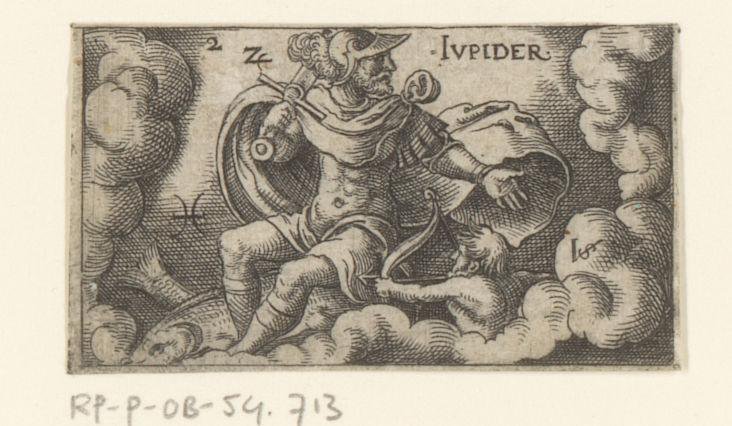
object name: print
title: Personificaties van zeven planeten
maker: virgilius solis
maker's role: draughtsman, print maker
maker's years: 1514-1562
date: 1524-1562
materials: paper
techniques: engraving, etching, intaglio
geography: nuremberg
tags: clouds, (story of) jupiter (zeus), jupiter (planet)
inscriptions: number: ‘54’, collector's mark: Lugt 2228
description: Maakt deel uit van een serie die bestaat uit vier prenten met zeven personificaties van planeten en een cartouche met titel.